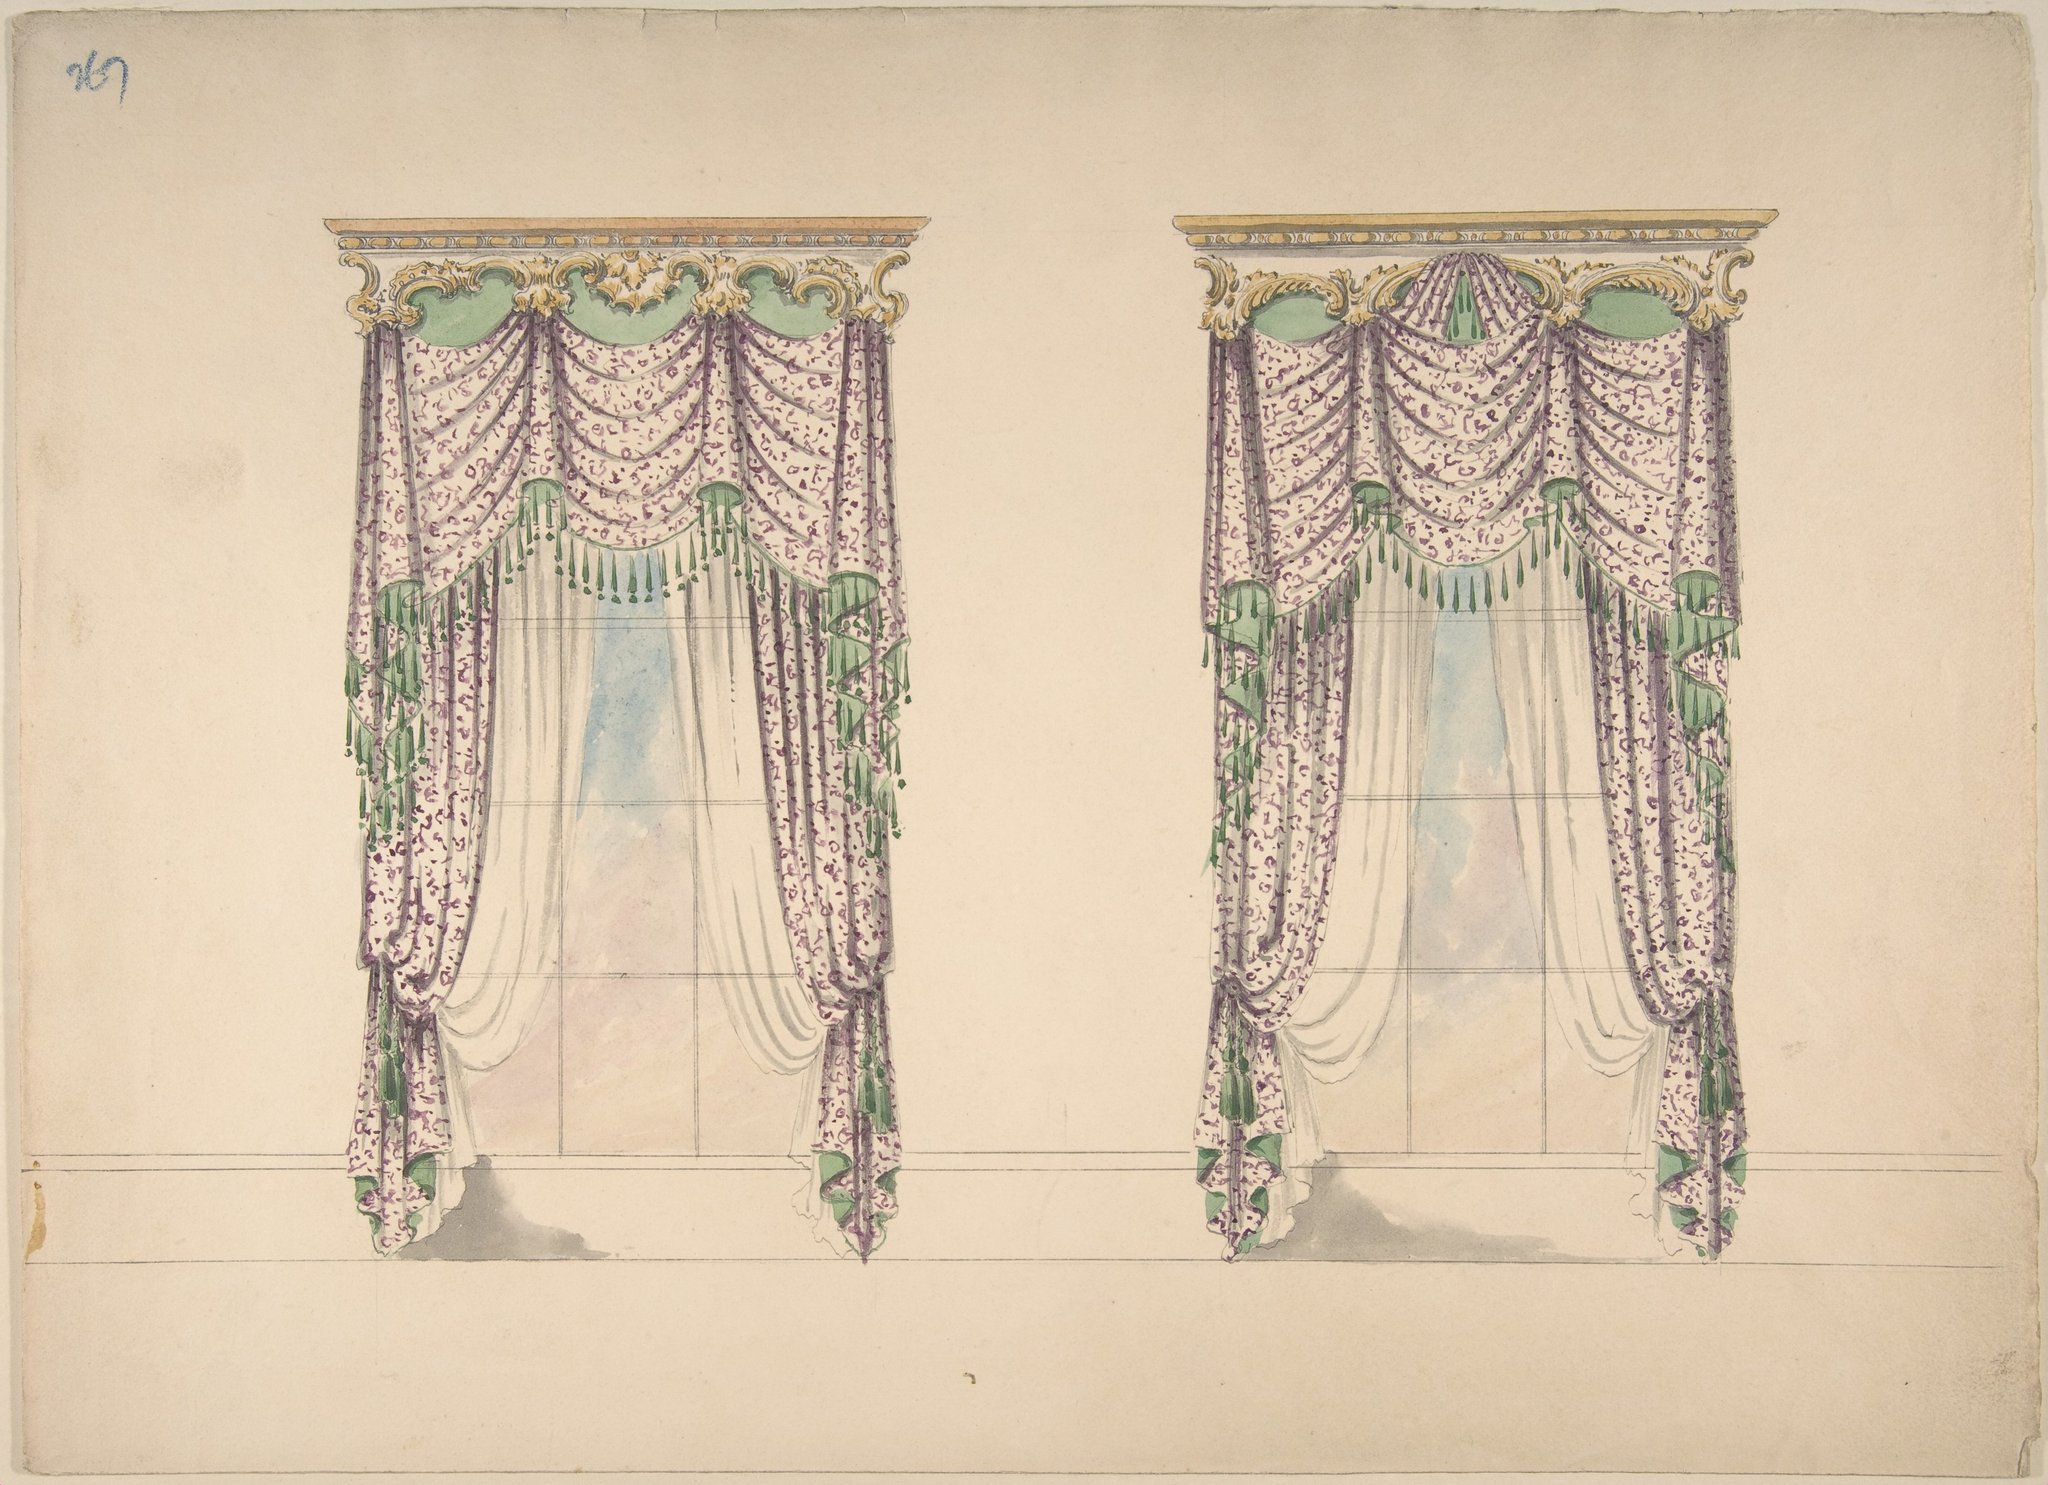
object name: drawing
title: Design for Pink and White Curtains with Green Fringes, and Gold and White Pediments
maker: anonymous, british, 19th century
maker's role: artist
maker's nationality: british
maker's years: 1800-1900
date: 1820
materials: ink, watercolor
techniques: brush, pen, wash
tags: windows,curtains